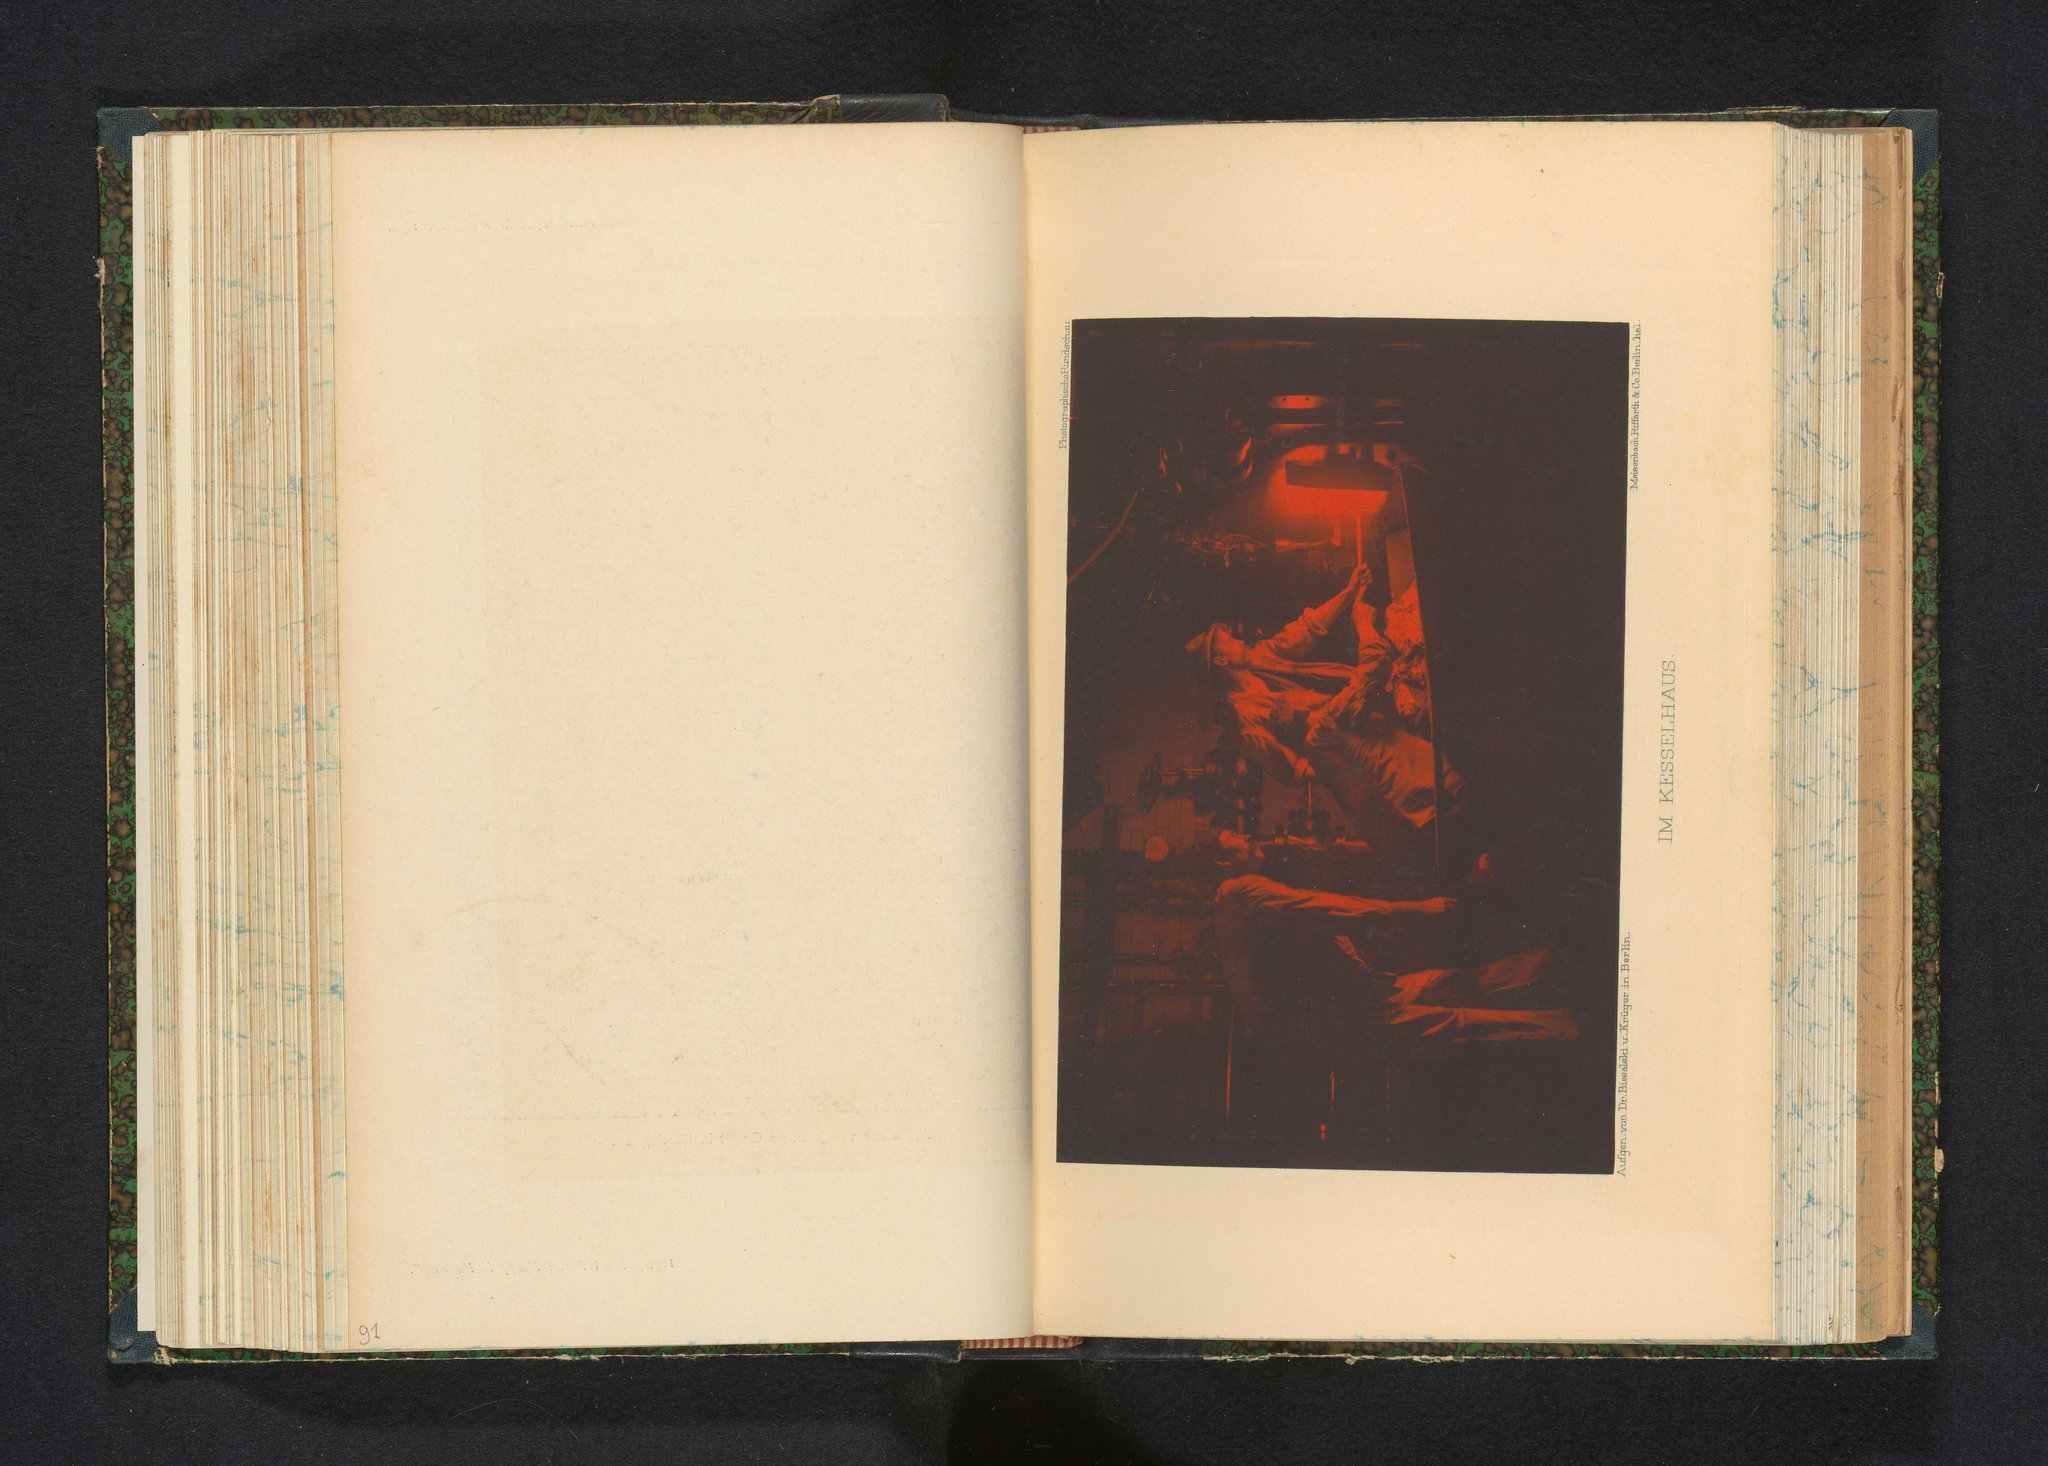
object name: page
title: Drie mannen aan het werk met een verbrandingsoven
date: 1894-1899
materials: paper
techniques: photoaquatint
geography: berlin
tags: fire, oven, furnace ~ interior of industrial structure (+ men (labourers))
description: Prent op tweede ongenummerde pagina na pagina 160.